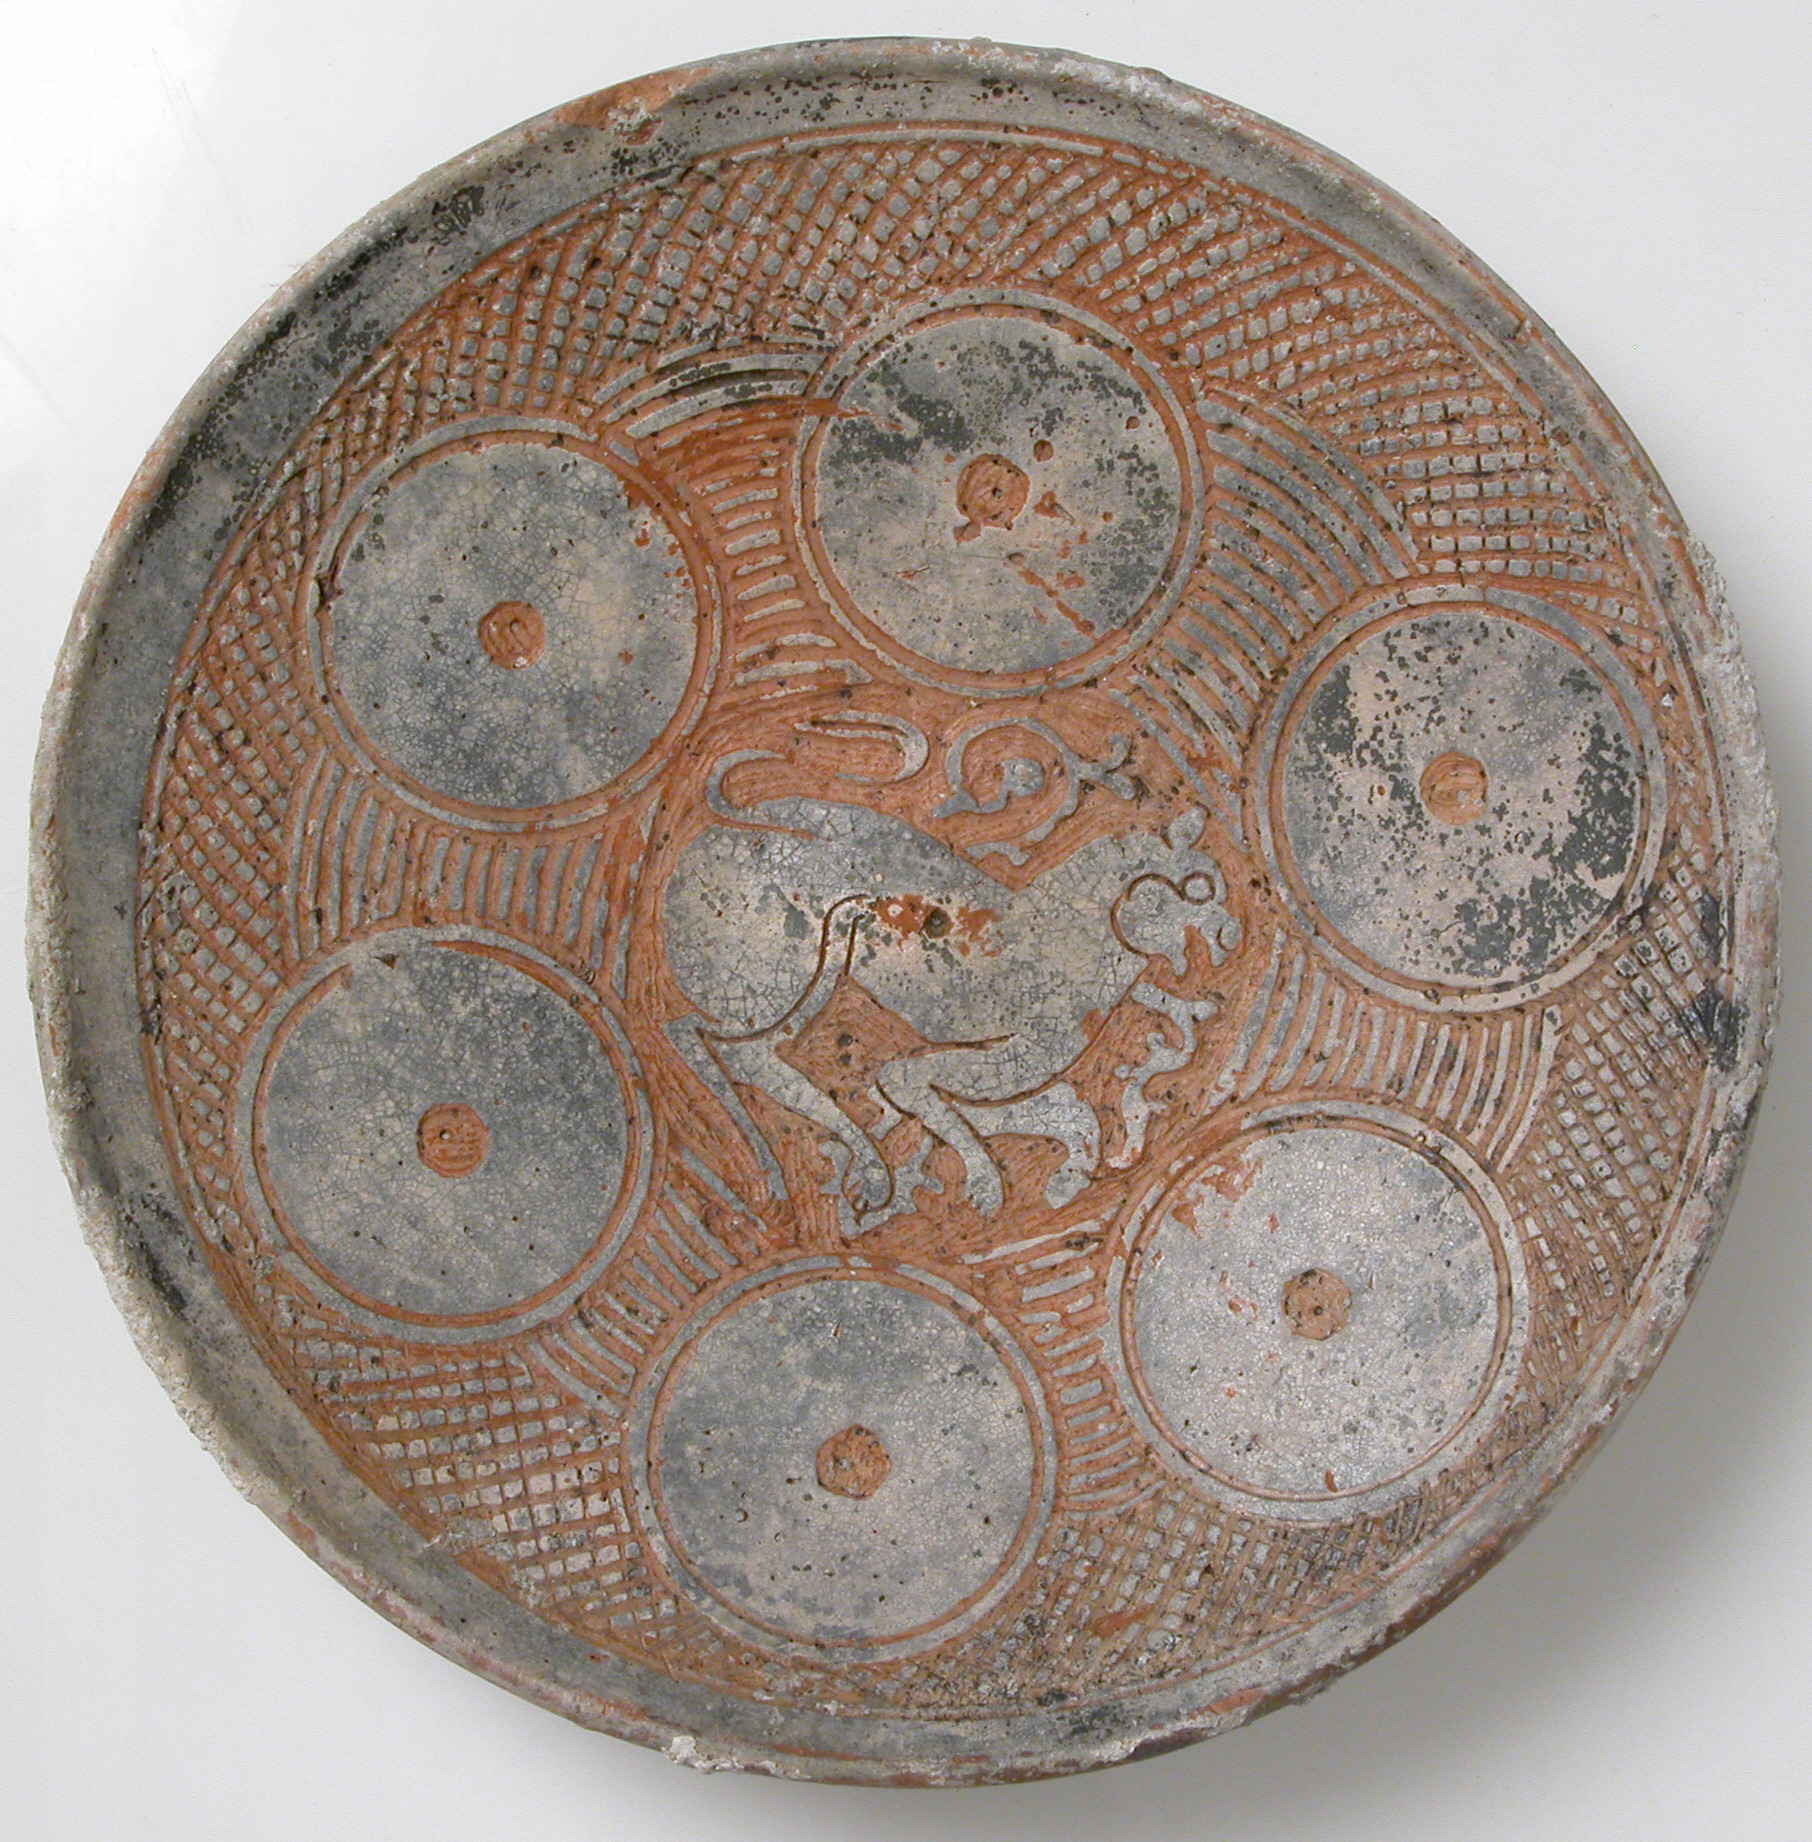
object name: bowl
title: Bowl with Lioness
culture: byzantine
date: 1100-1300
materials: earthenware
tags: animals